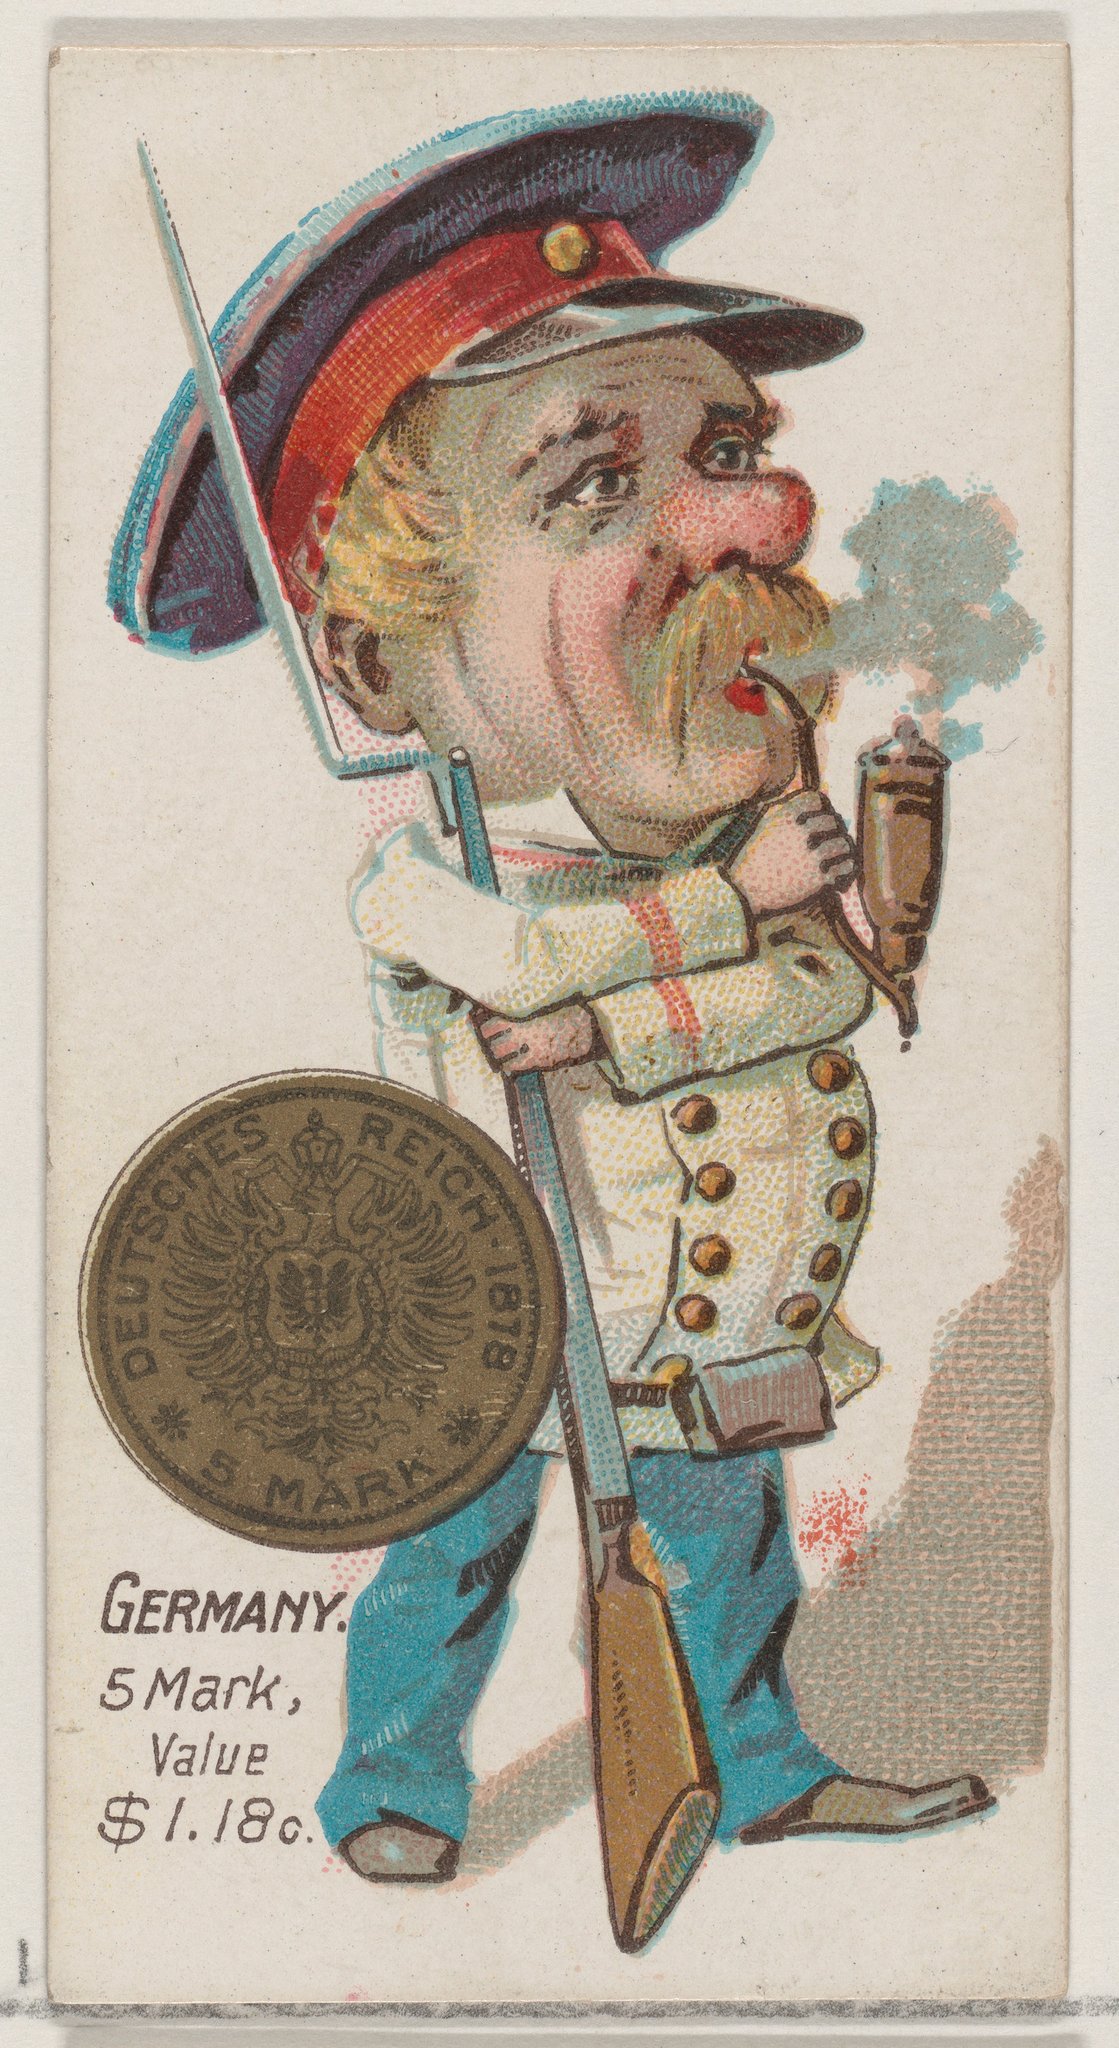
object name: print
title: Germany, 5 Mark, from the series Coins of All Nations (N72, variation 1) for Duke brand cigarettes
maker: w. duke, sons & co.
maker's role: publisher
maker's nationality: american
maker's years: 1870-1920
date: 1889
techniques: color lithograph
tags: men,coins